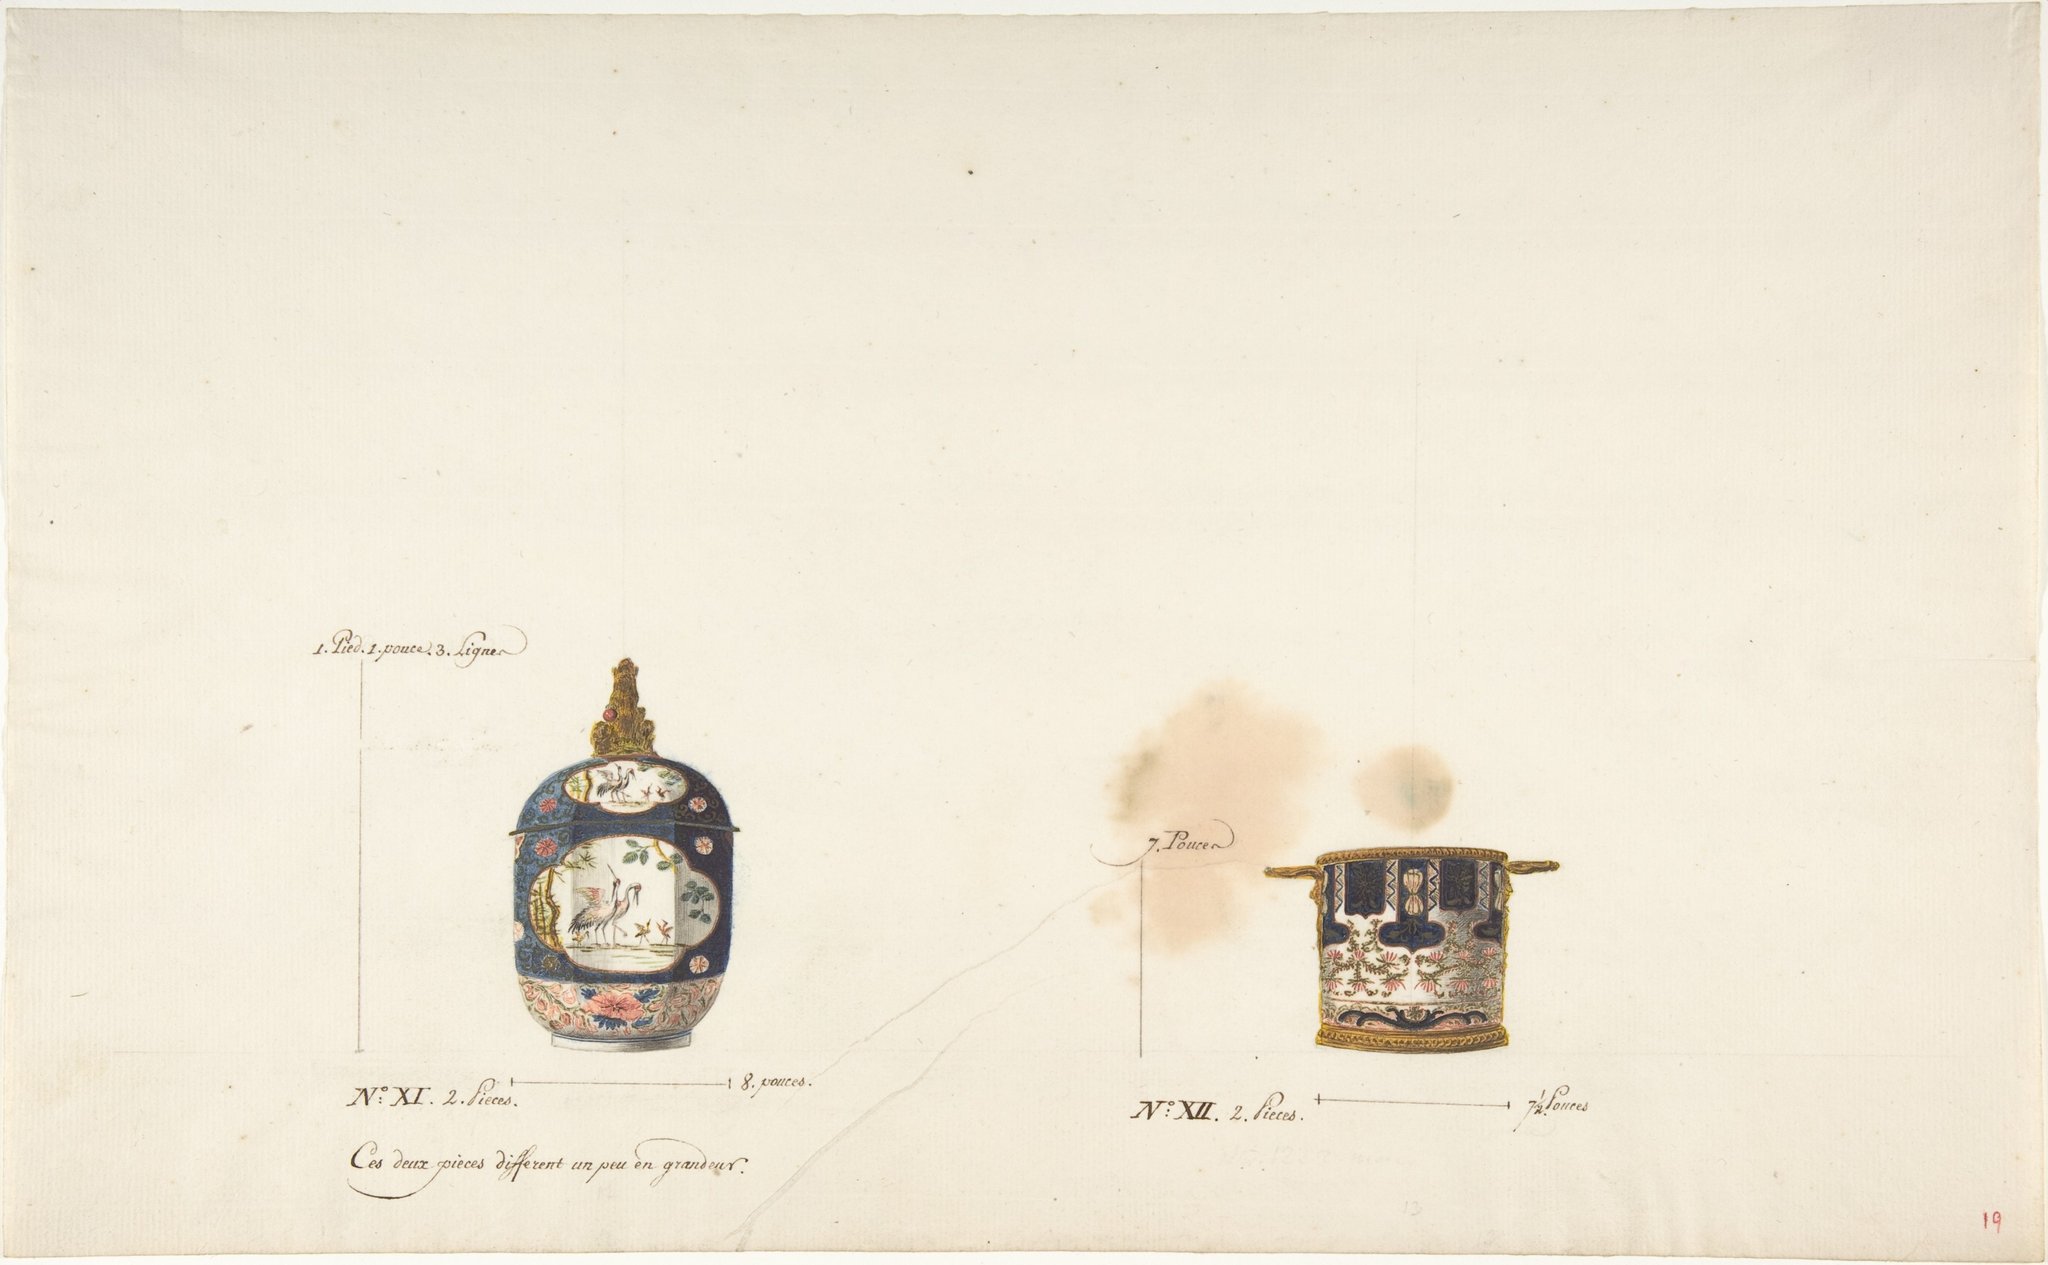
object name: drawing ornament architecture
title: Design for Two Vases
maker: anonymous, french, 18th century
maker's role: artist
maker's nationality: french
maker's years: 1700-1800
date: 1770-1785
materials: ink, watercolor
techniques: pen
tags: cranes,flowers,leaves,vases